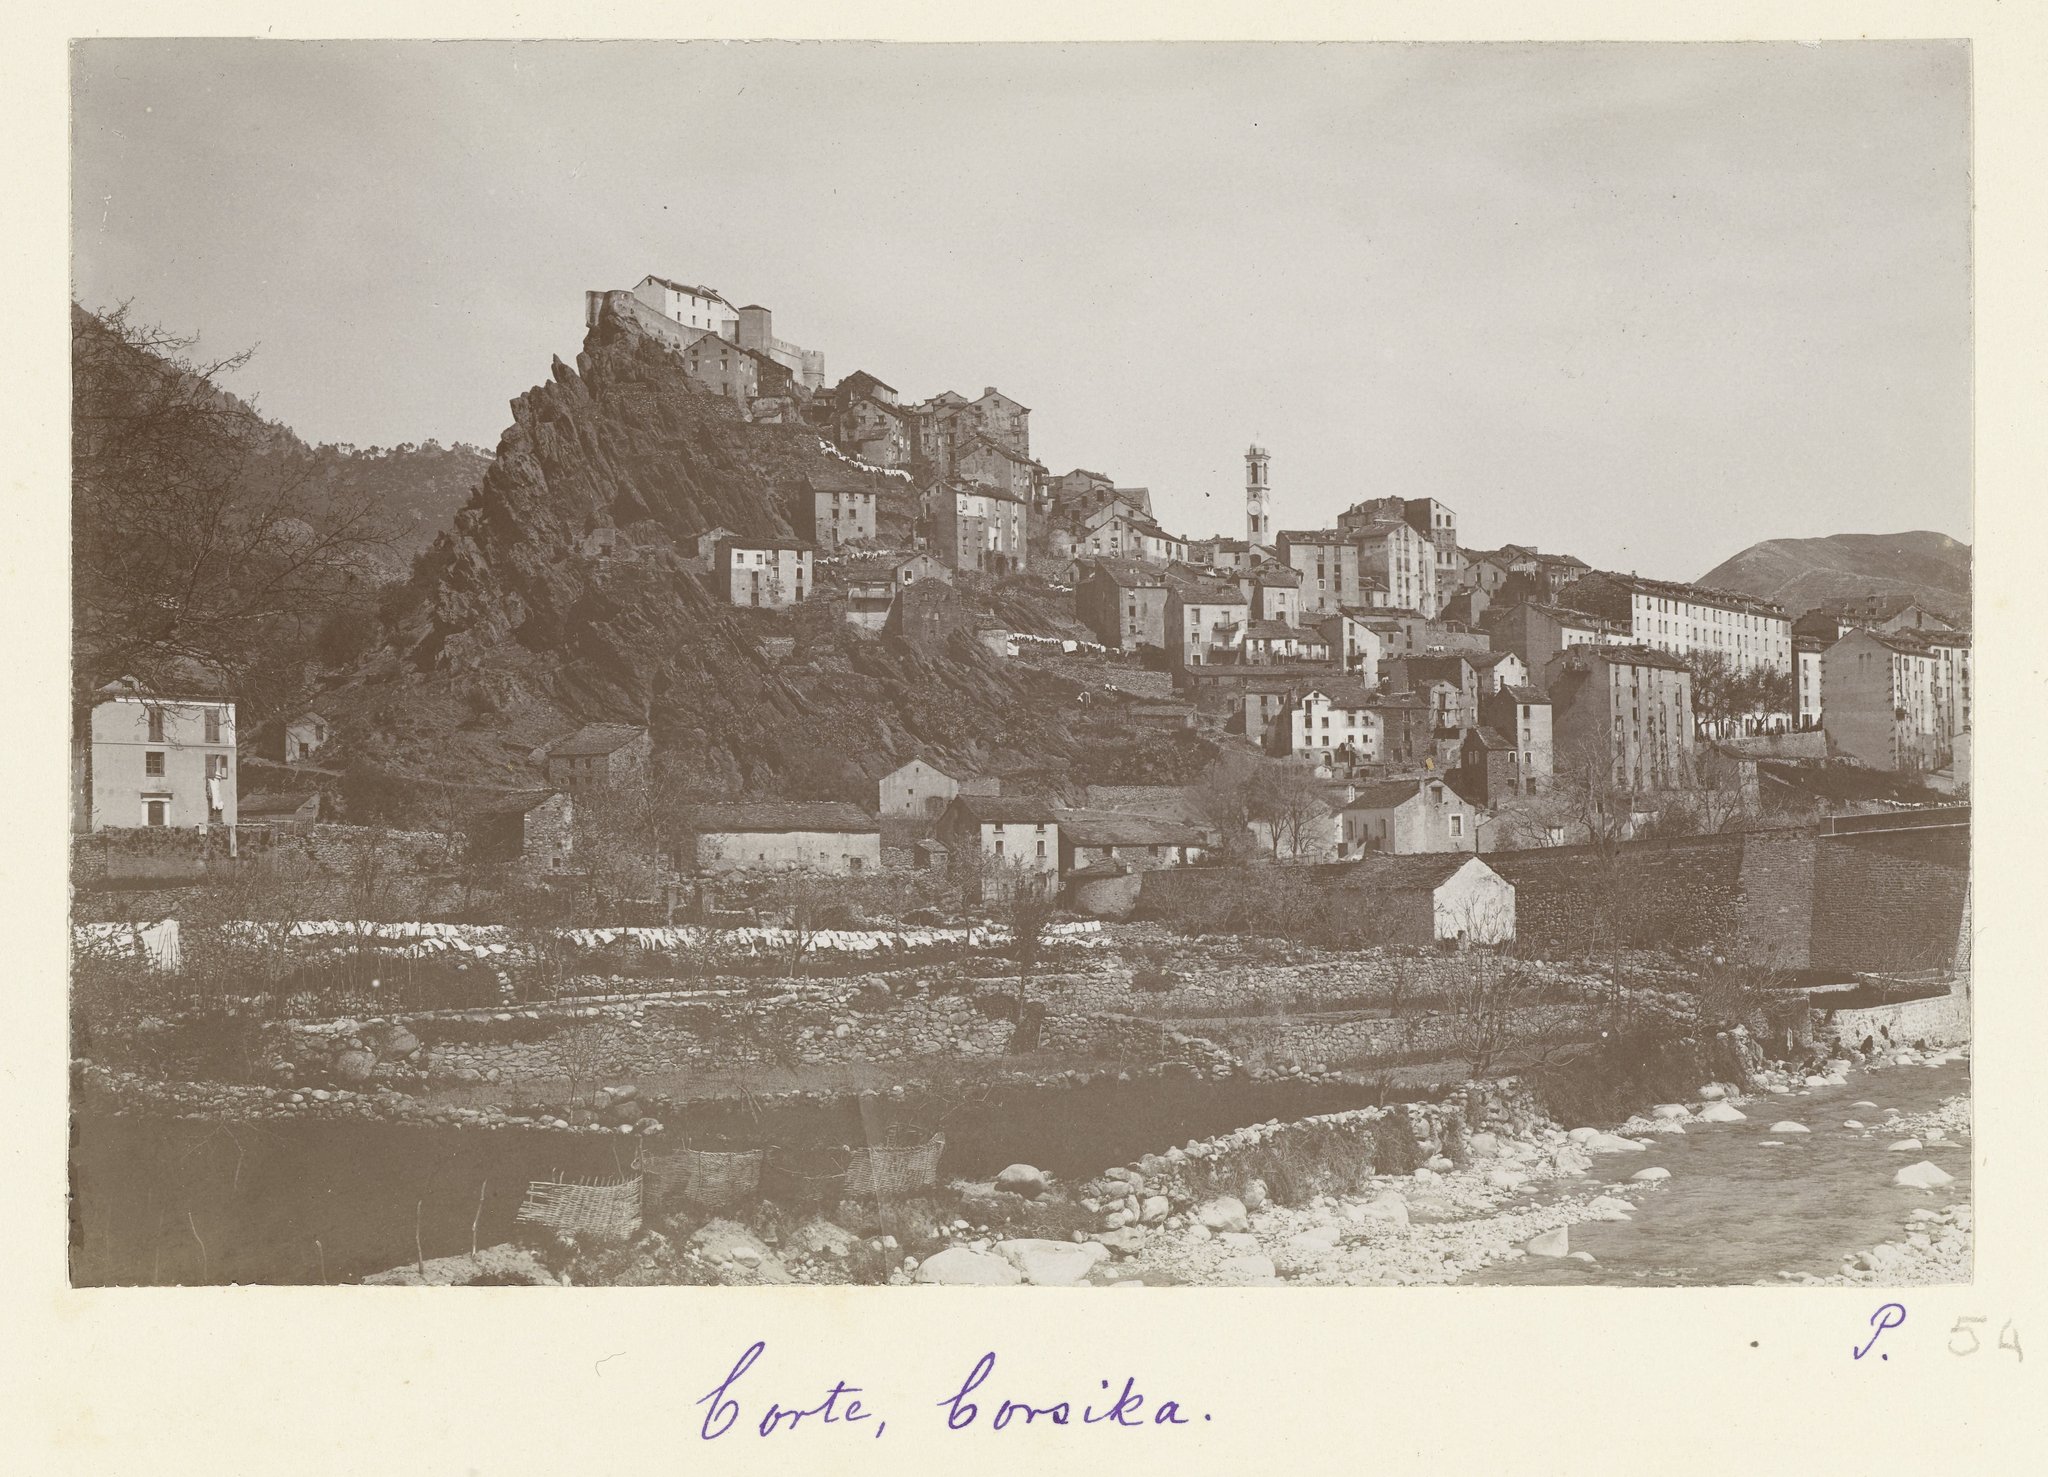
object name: photograph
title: Gezicht op de stad Corte, gebouwd op een heuvel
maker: henry pauw van wieldrecht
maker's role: fotograaf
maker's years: 1863-1912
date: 1886-1896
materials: cardboard, photographic support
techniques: albumen print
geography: corsica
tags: corsica